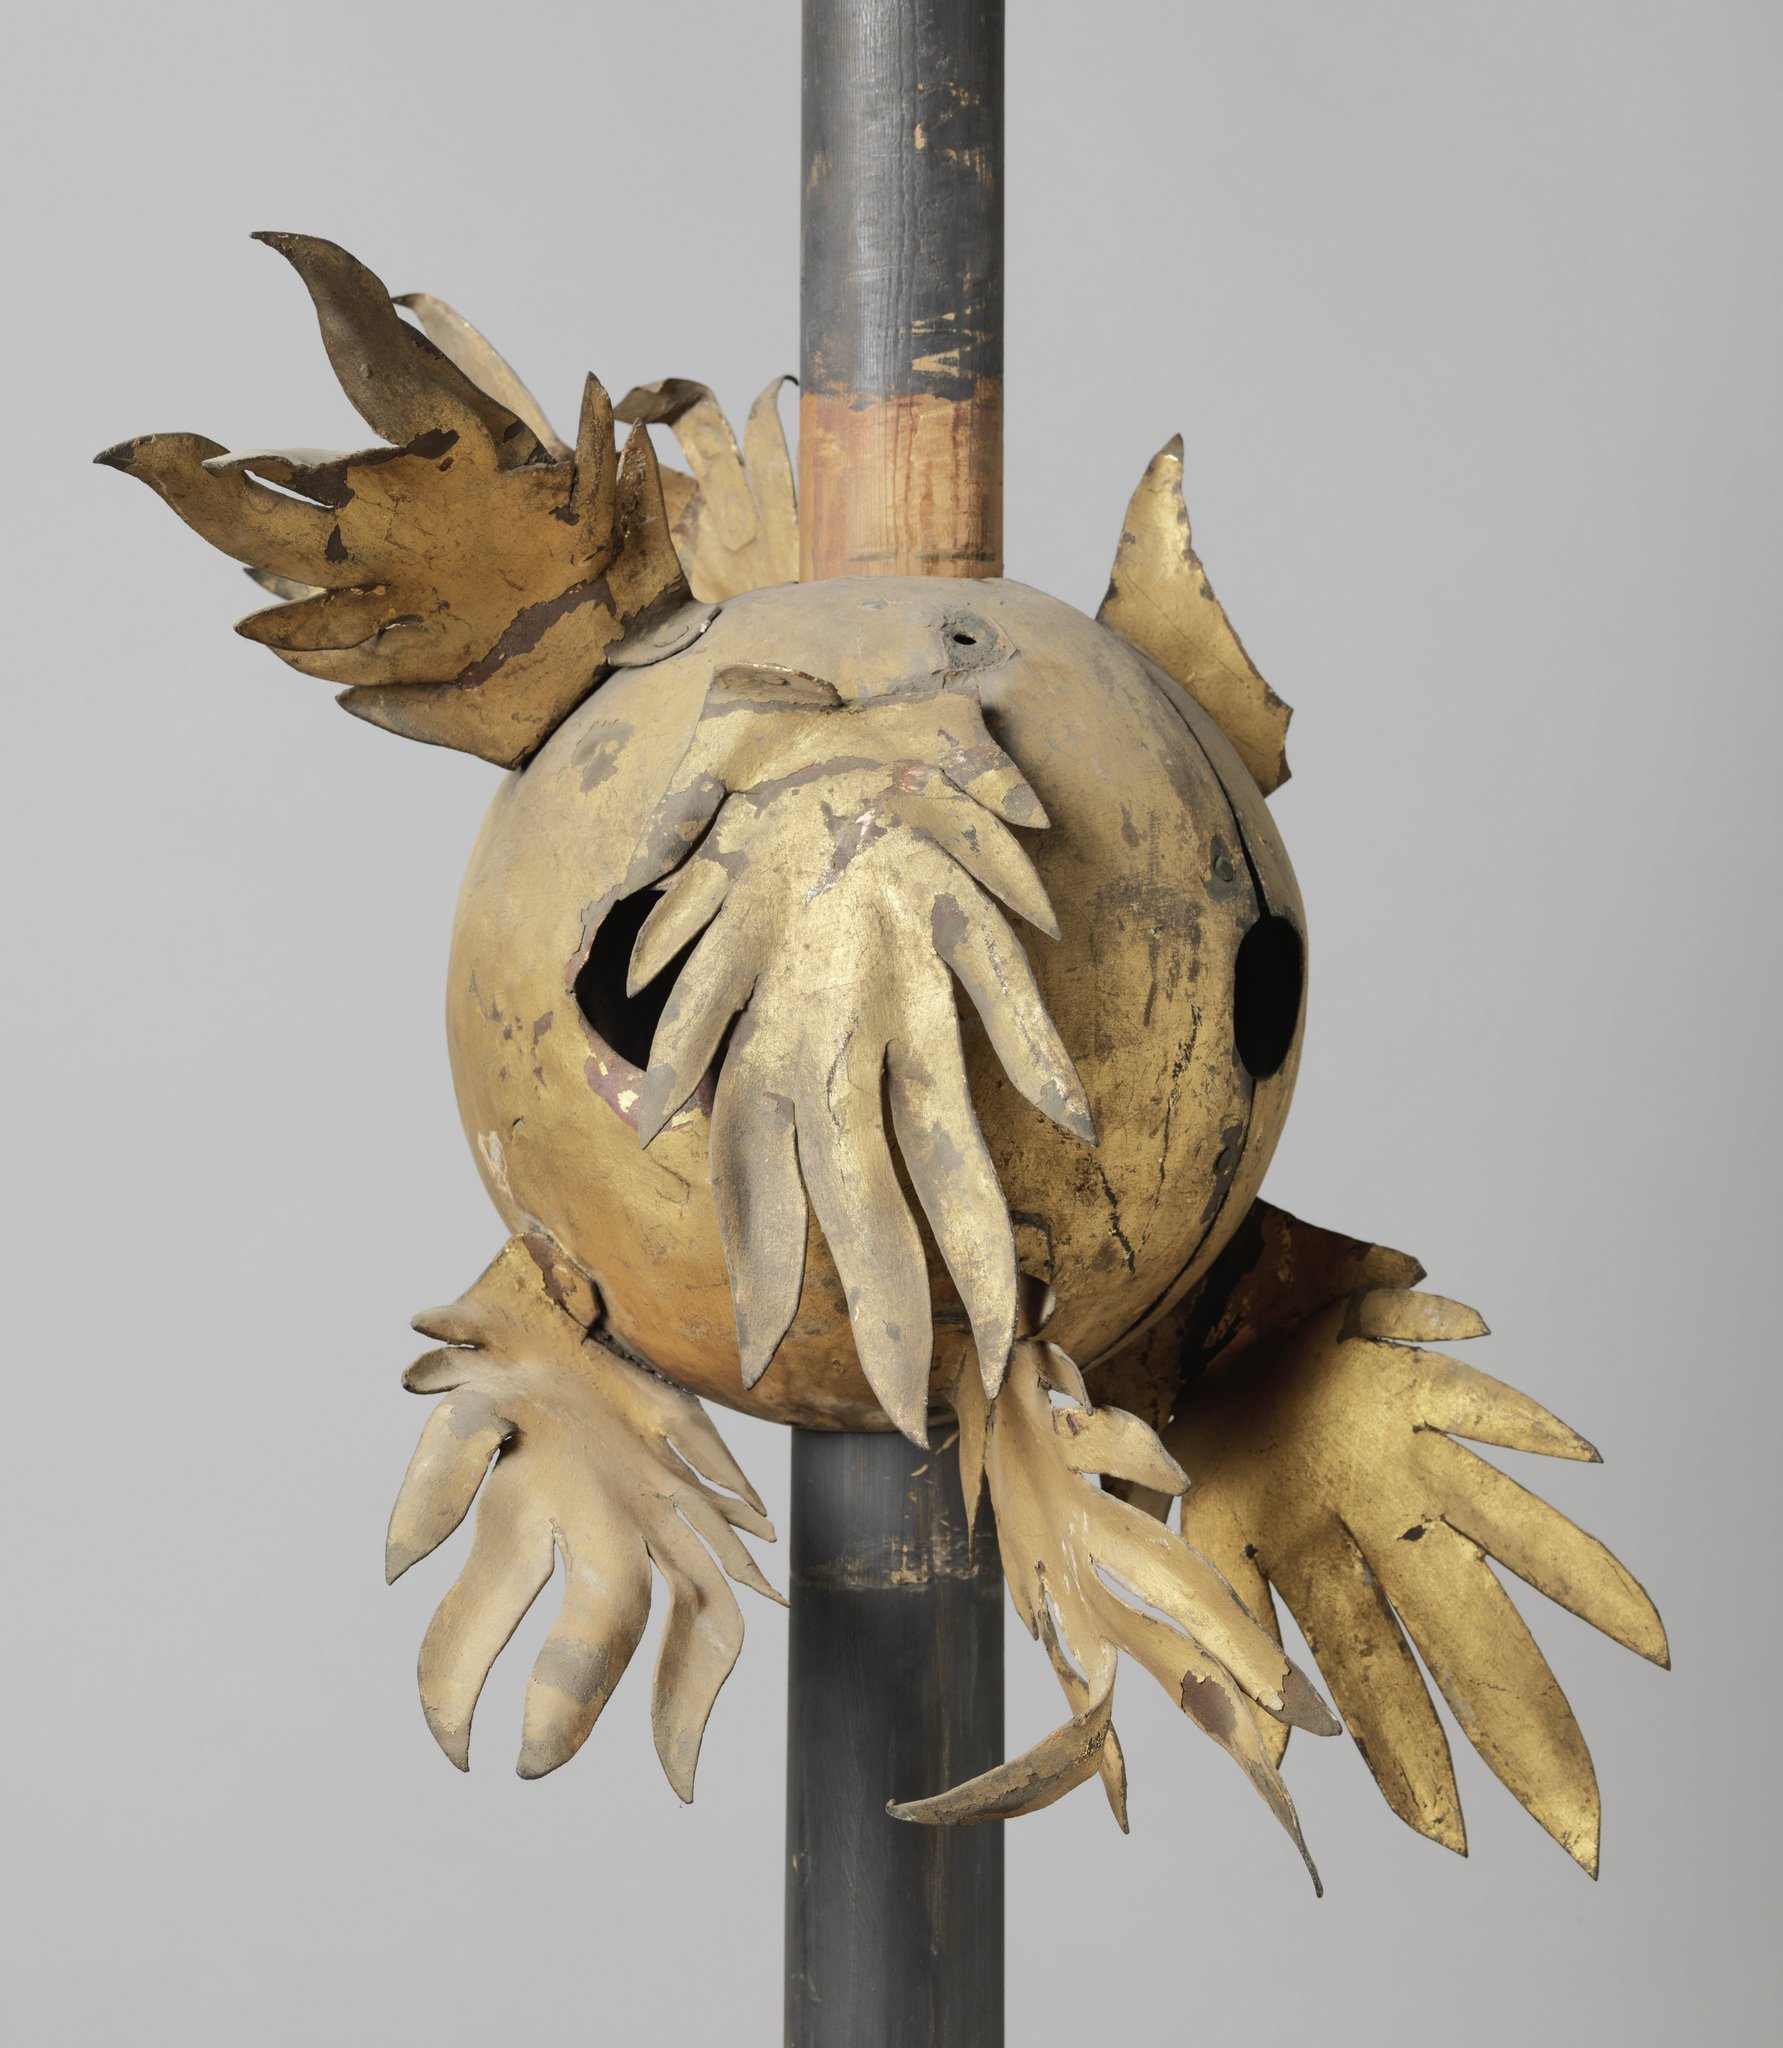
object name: weather vane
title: Vergulde bol met acht vlammen (één los, in tweeën)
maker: Anonymous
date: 1500-1900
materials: iron, wood